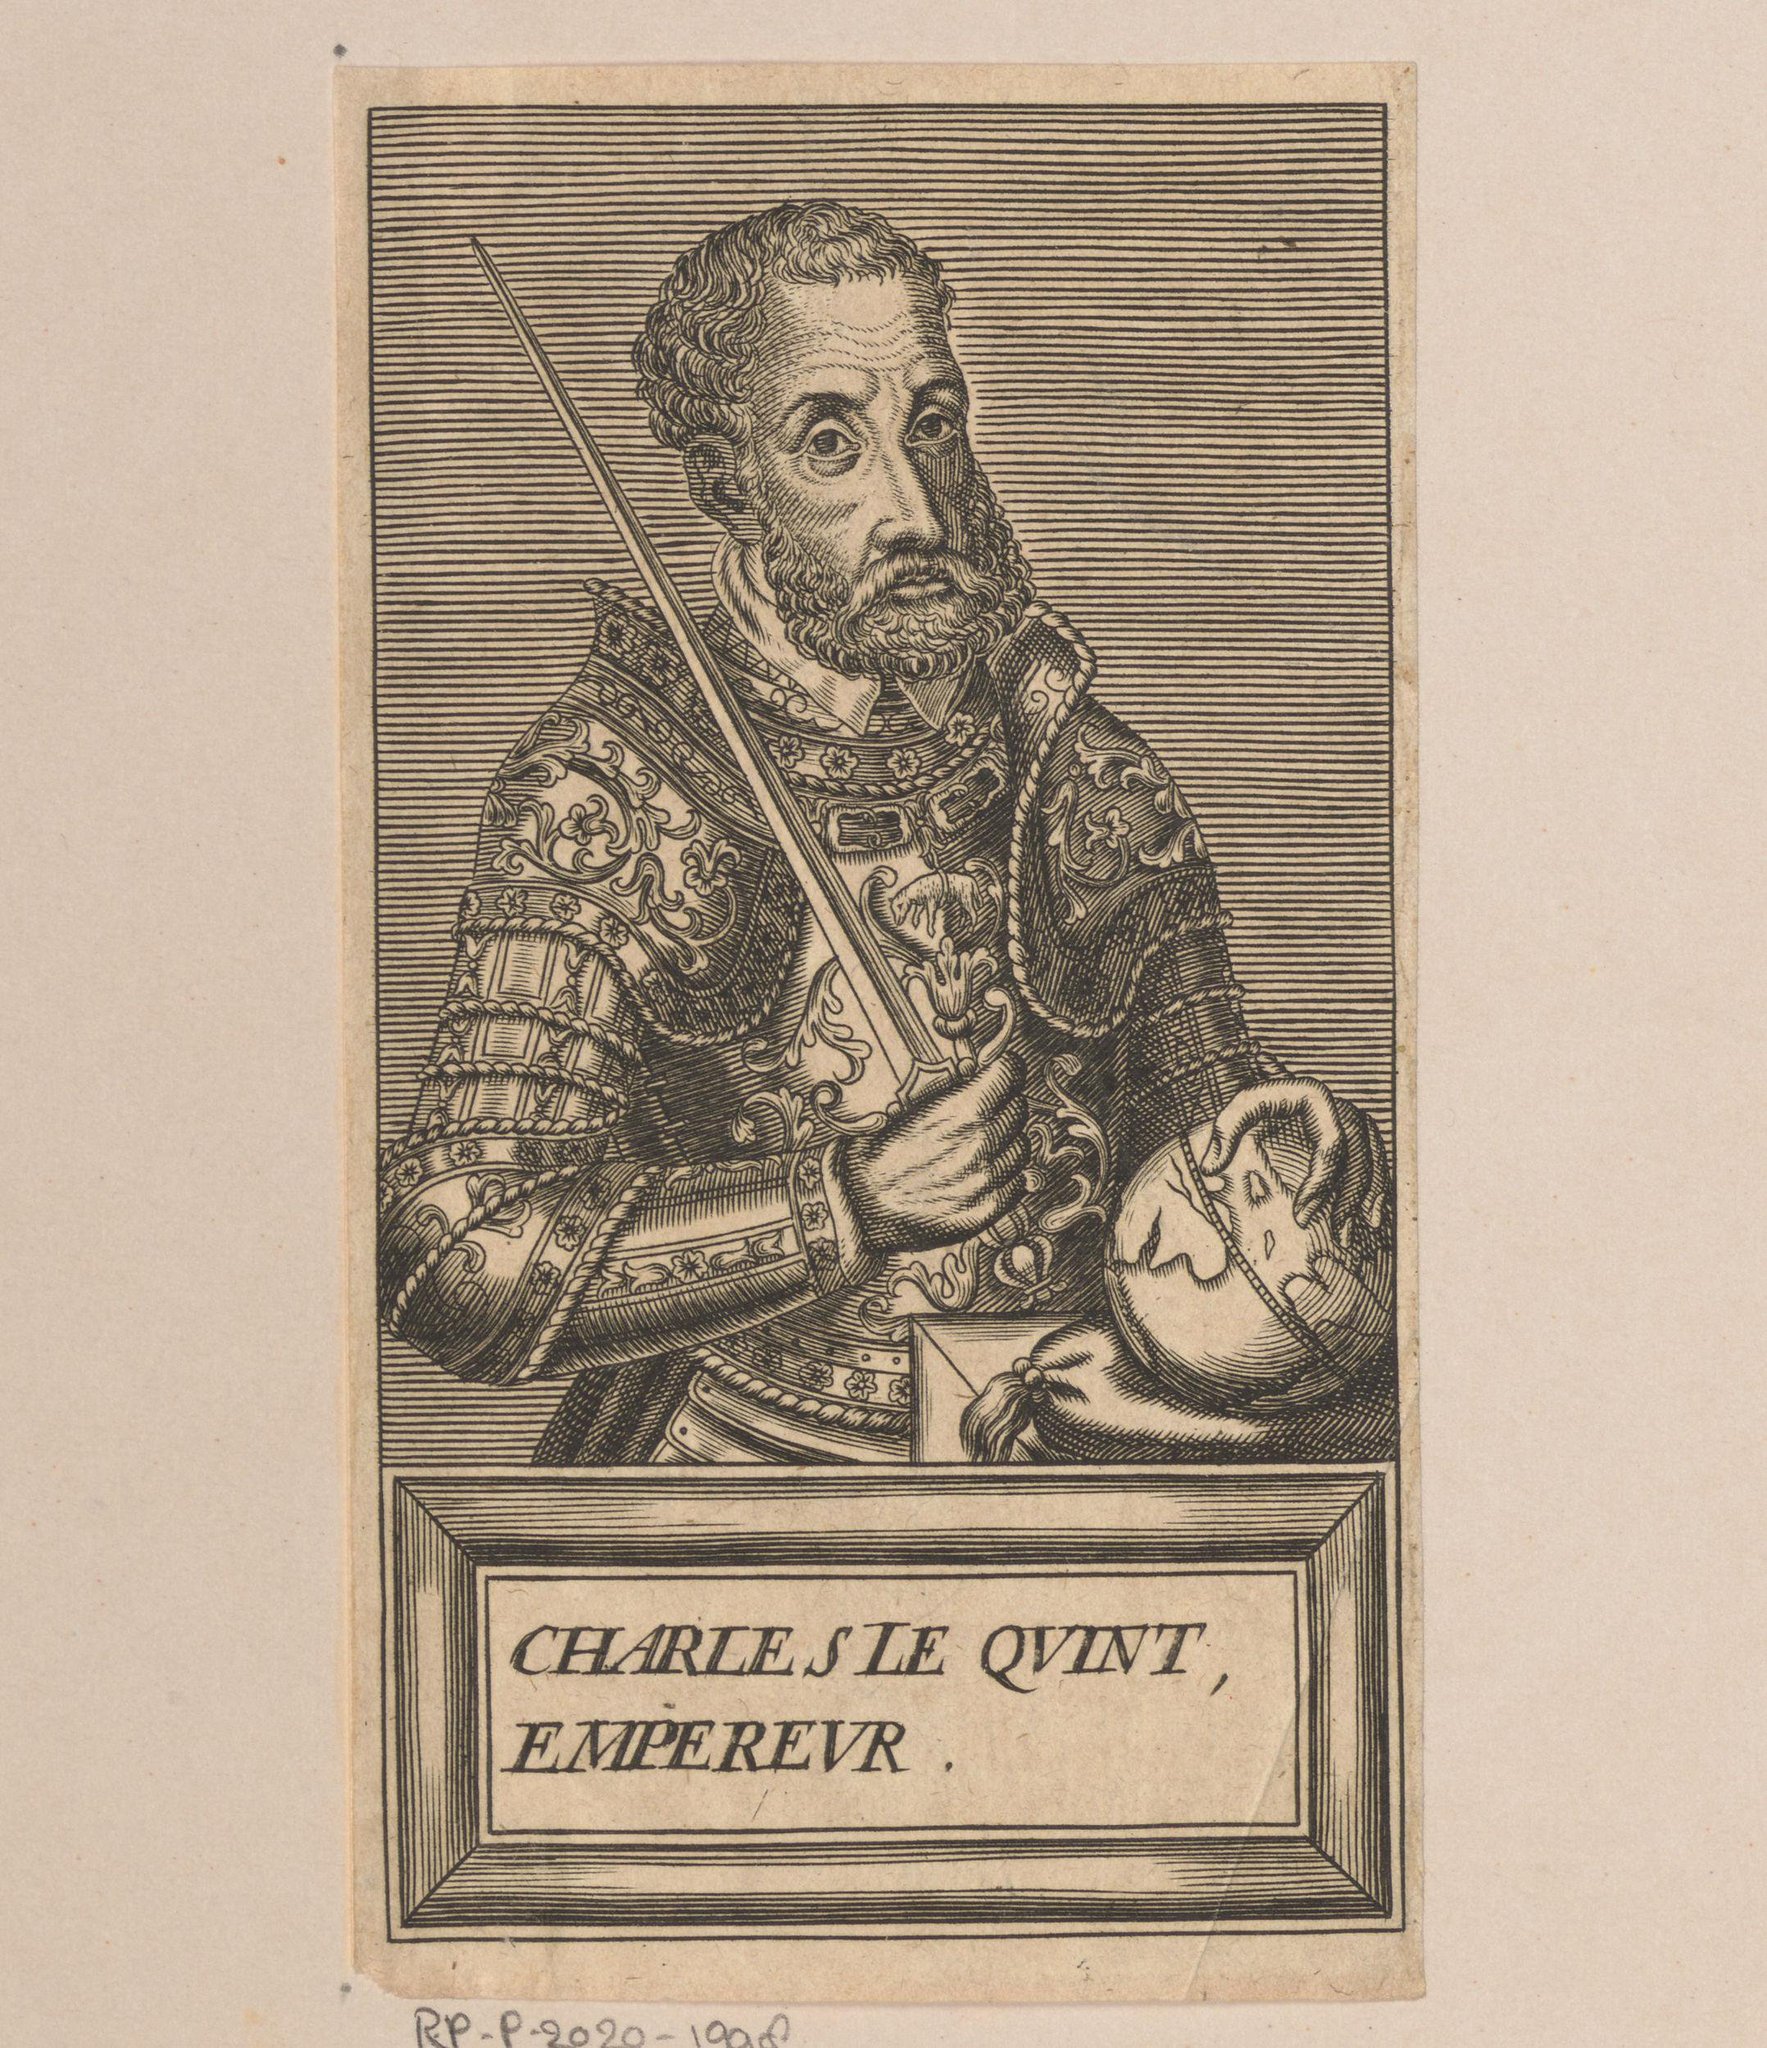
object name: print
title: Portret van keizer Karel V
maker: Anonymous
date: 1600-1699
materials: paper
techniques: engraving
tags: ghent, charles v (holy roman emperor and king of spain), historical persons, knighthood order of the golden fleece, king